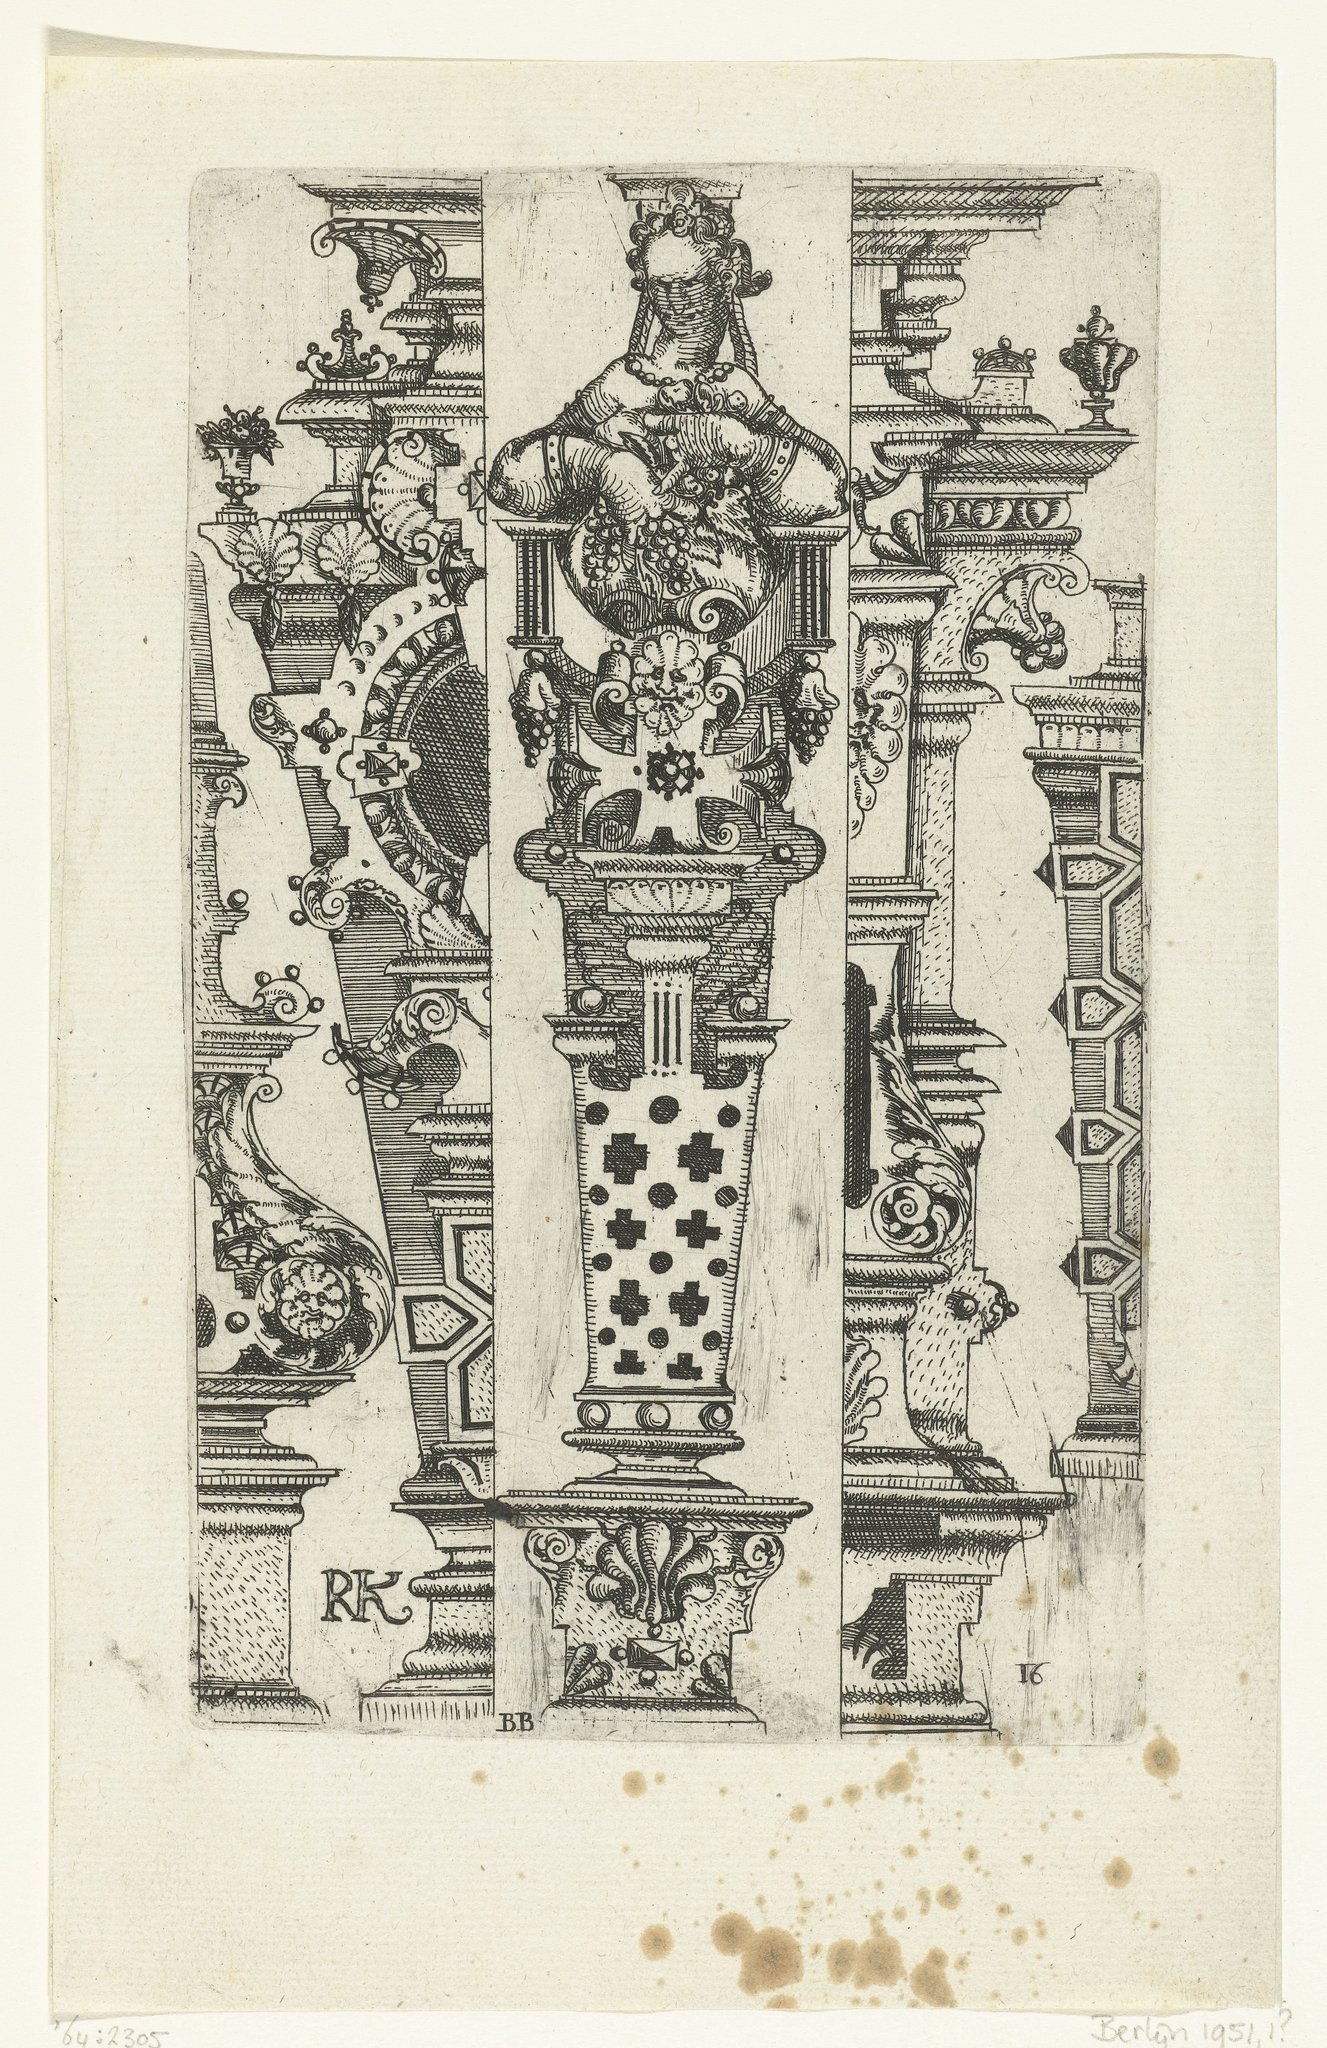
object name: print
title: Livre d' Architecture contenant plusieurs beaux ornementz (...)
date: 1622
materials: paper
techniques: etching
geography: germany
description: Het blad is verticaal verdeeld in drie vakken: links de helft van een pinakel en de helft van een baluster of term, in het midden een term die eindigt in een vrouw met druiventrossen en rechts twee halve termen. Blad BB uit tweede editie van serie, bestaande uit 24 bladen.